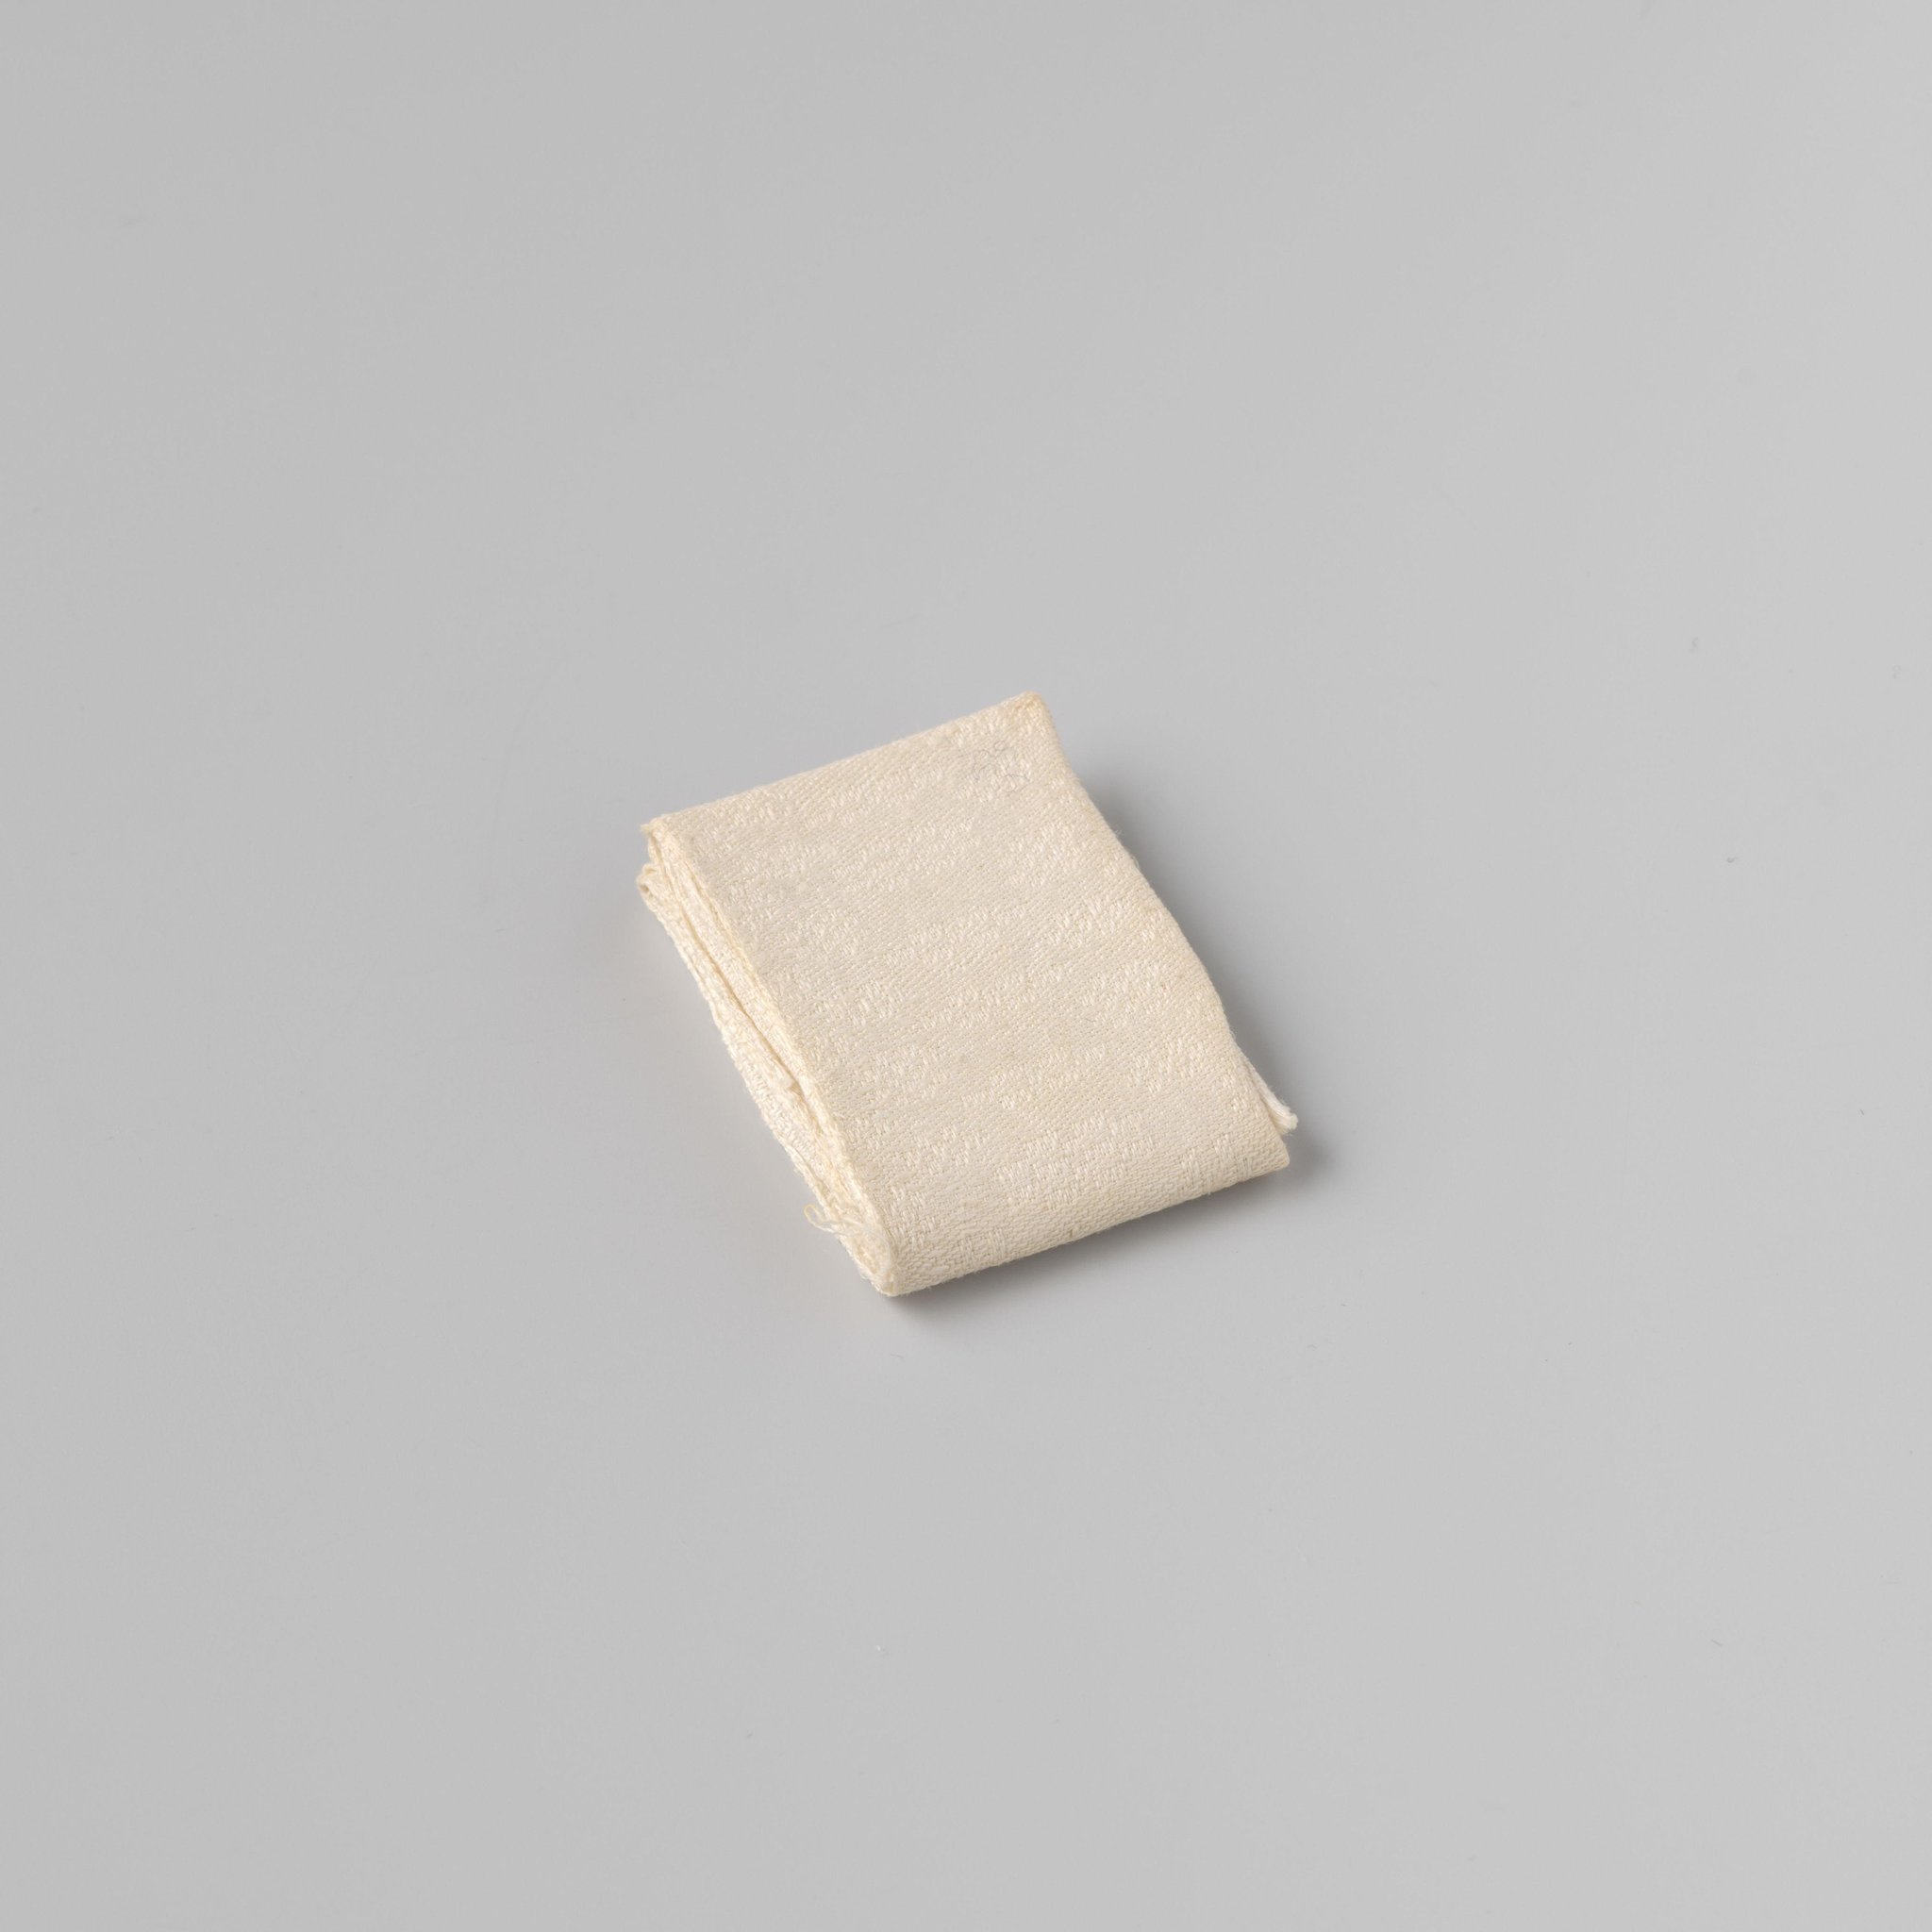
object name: miniature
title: Linnen servet van damastweefsel met pellenpatroon (motief III), geen zomenLinnen servet van damastweefsel met pellenpatroon (motief III), geen zomen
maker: Anonymous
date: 1690-1710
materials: linen